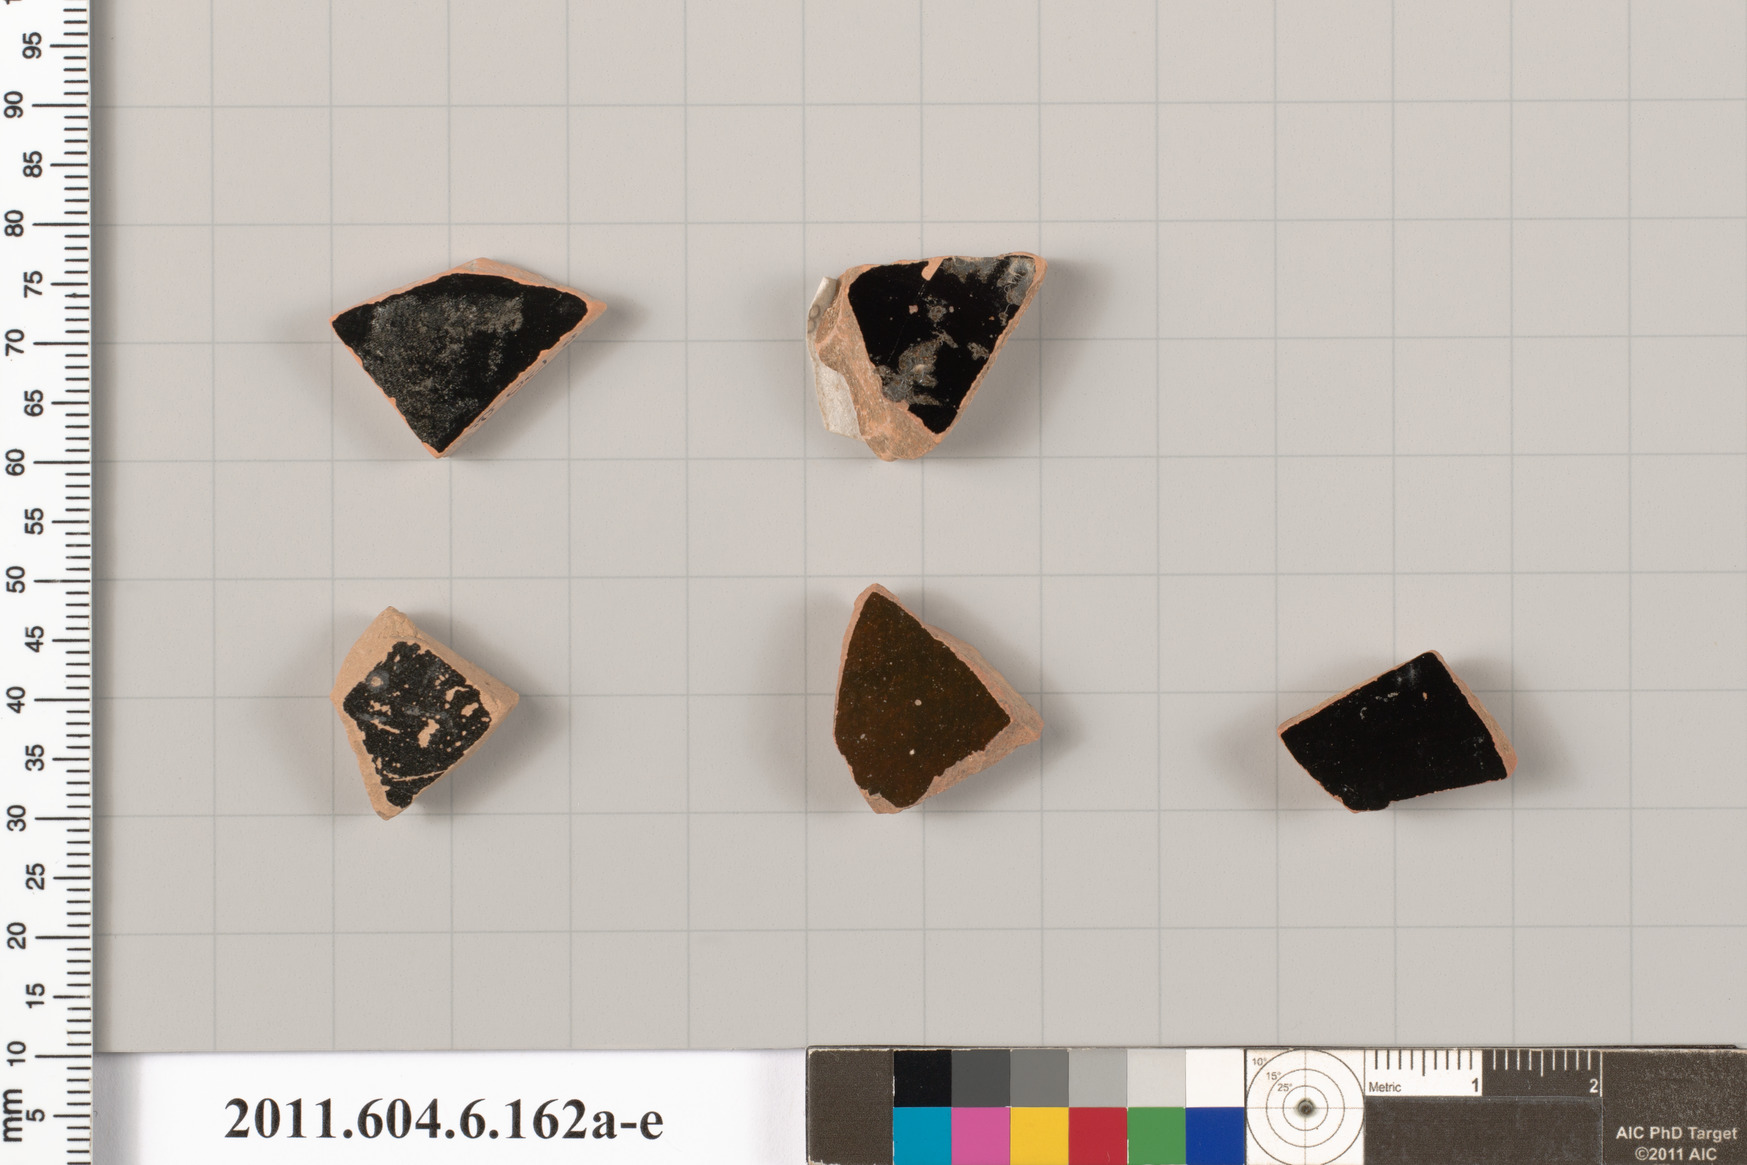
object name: undetermined open shape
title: Terracotta fragments of open shapes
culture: greek, attic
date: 600-401 BCE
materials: terracotta